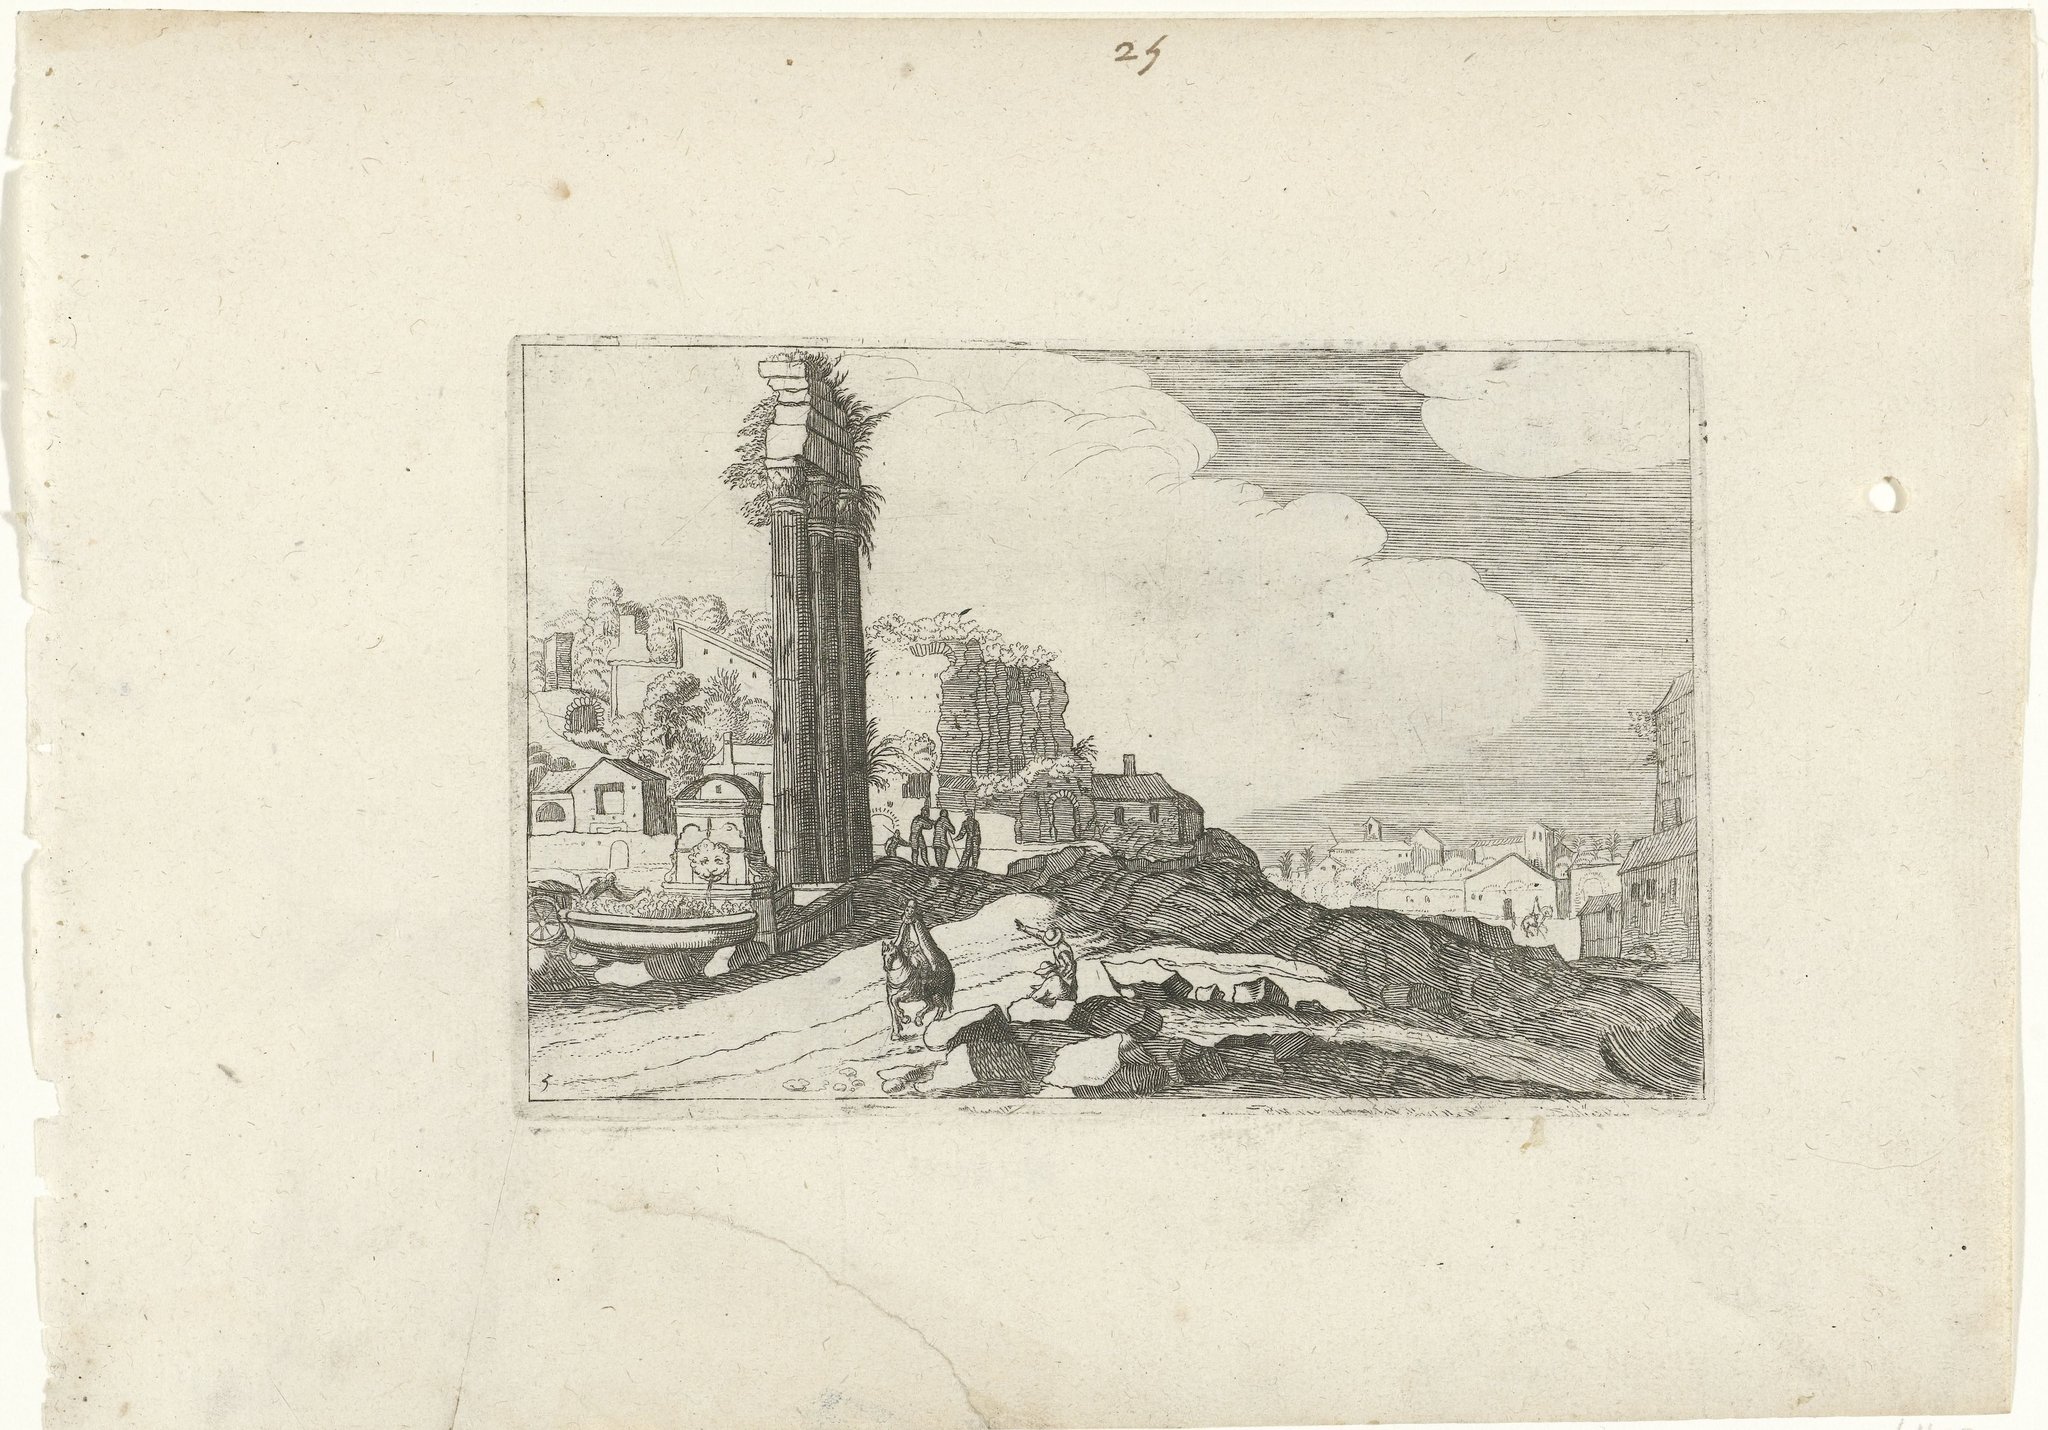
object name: print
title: Romeinse ruïnes en kustlandschappen (serie 2)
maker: Anonymous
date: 1594-1685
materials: paper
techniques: etching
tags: landscape with ruins, rome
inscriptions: collector's mark: Lugt 2228, inscription: ‘25’, collector's mark: Lugt 2760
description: De ruïne van de tempel van Castor en Pollux op het Forum Romanum in Rome. Daarnaast enkele figuren en een fontein. Op de weg rijdt een man te paard. Prent maakt deel uit van een serie Romeinse ruïnes en kustlandschappen naar prenten van Willem van Nieulandt. Deze serie is een kopie van de serie, die Claes Jansz Visscher naar Van Nieulandt maakte.